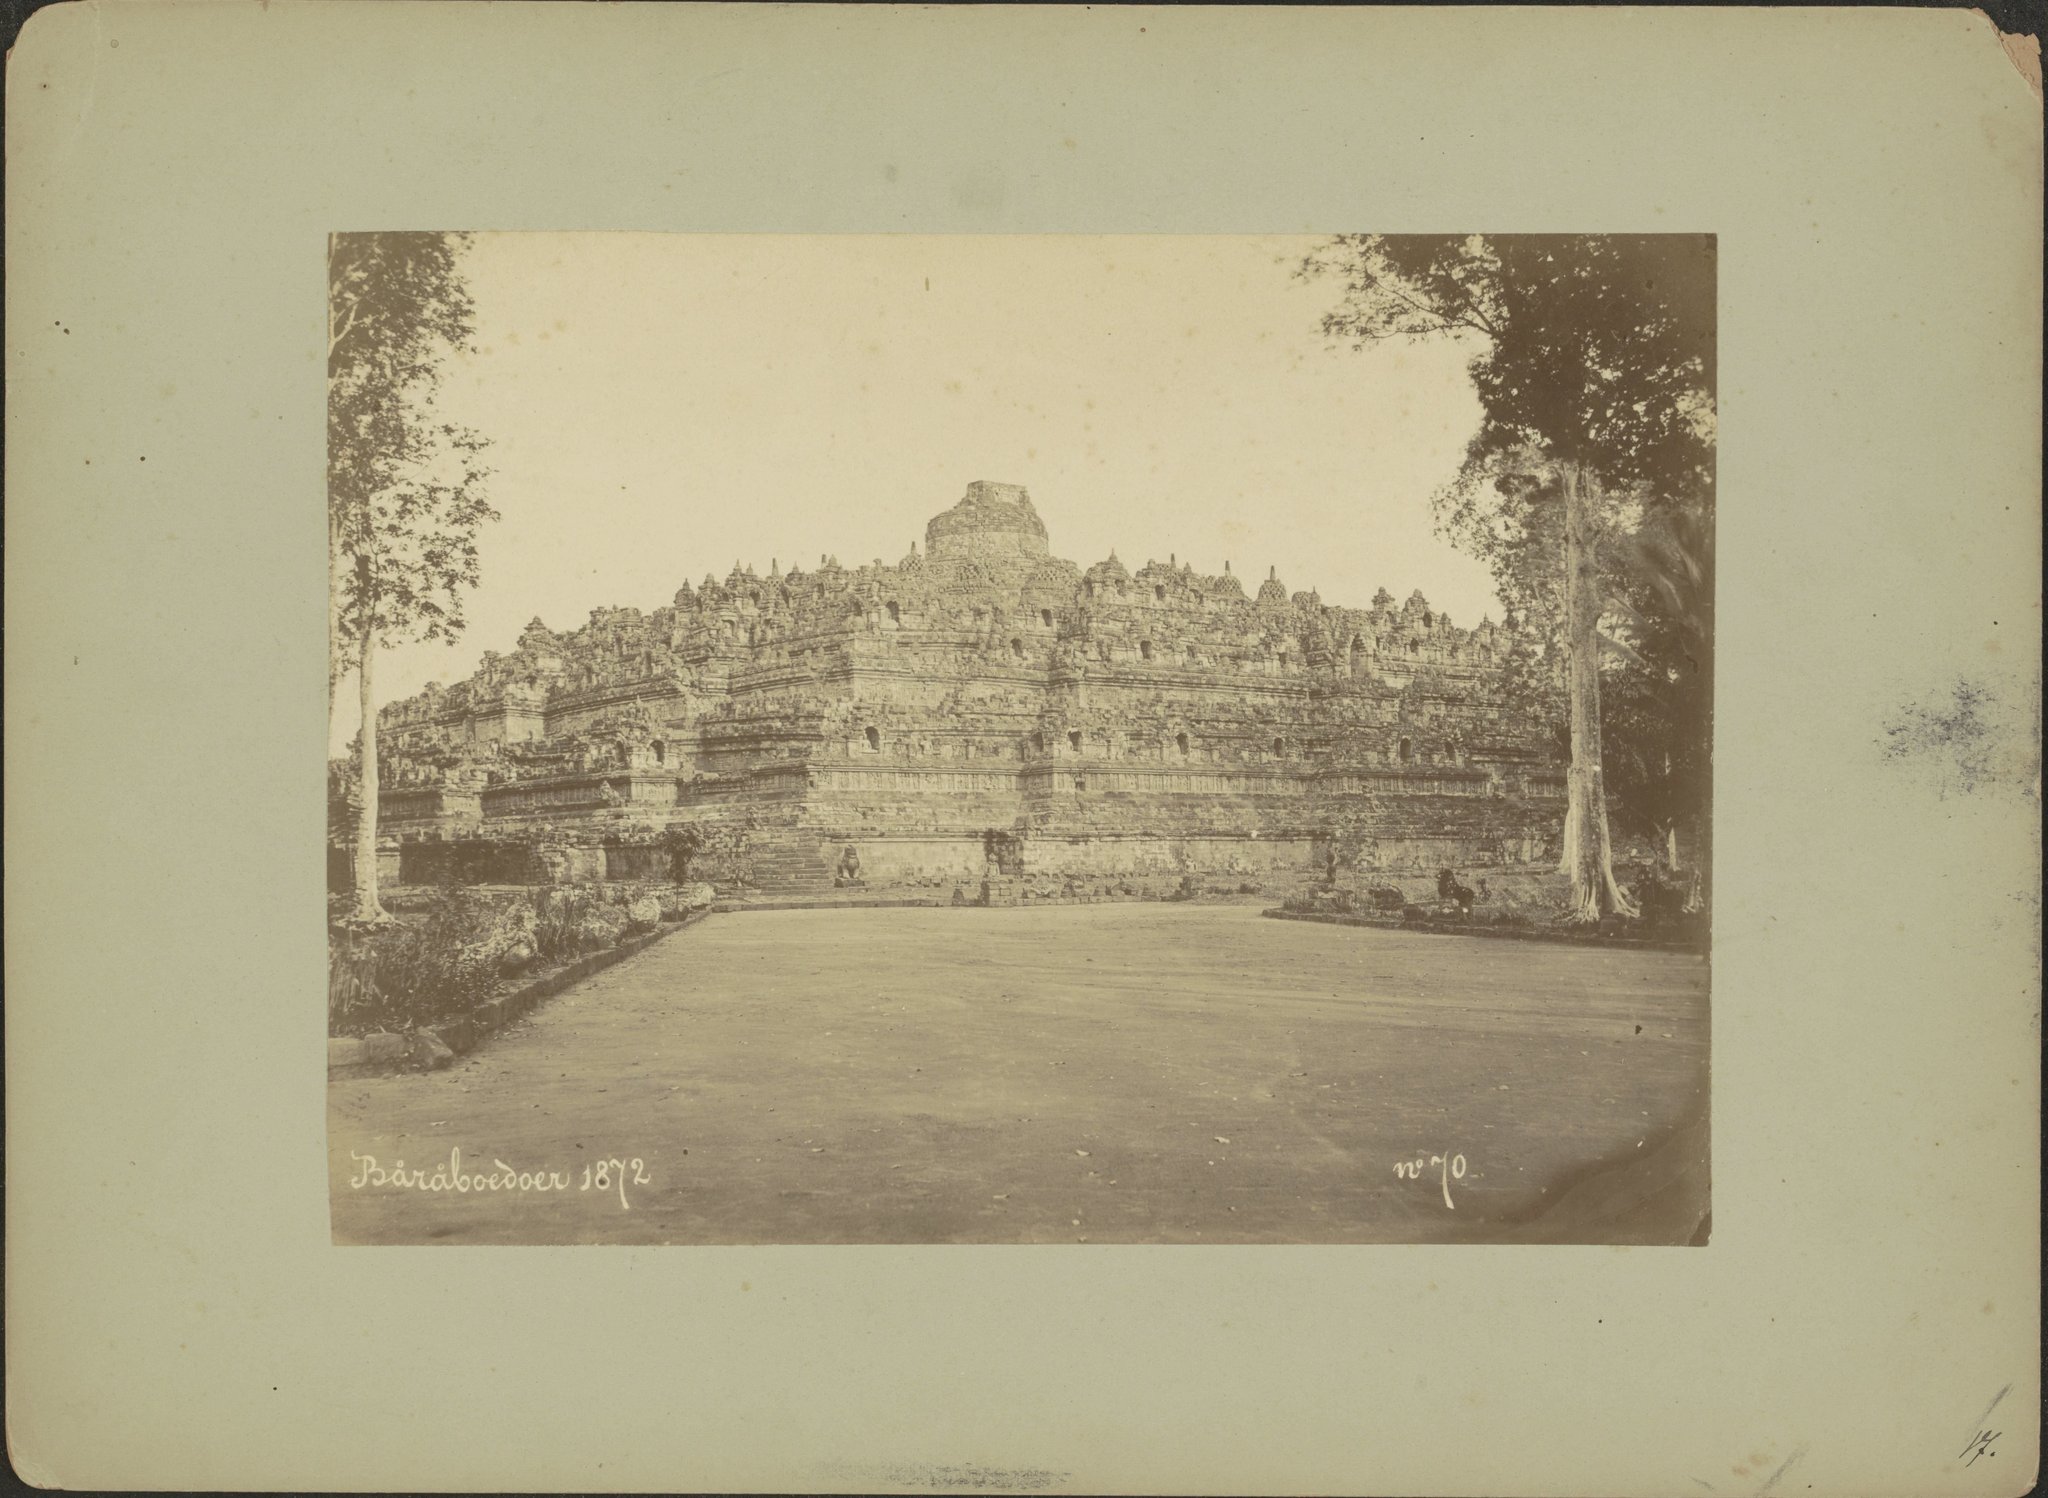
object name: photograph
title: Gezicht op de Borobudur op Java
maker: kassian céphas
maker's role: fotograaf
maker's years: 1845-1912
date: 1872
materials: cardboard, paper, photographic support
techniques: albumen print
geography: borobudur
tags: temple, shrine ~ hinduism, buddhism, jainism, java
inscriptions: inscription: ‘Boroboedoer tusschen Magelang en Djocja.’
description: Onderdeel van Reisalbum met foto's van bezienswaardigheden in Marseille, Port Said, Aden, Bombay, Colombo, Singapore en Nederlands-Indië.